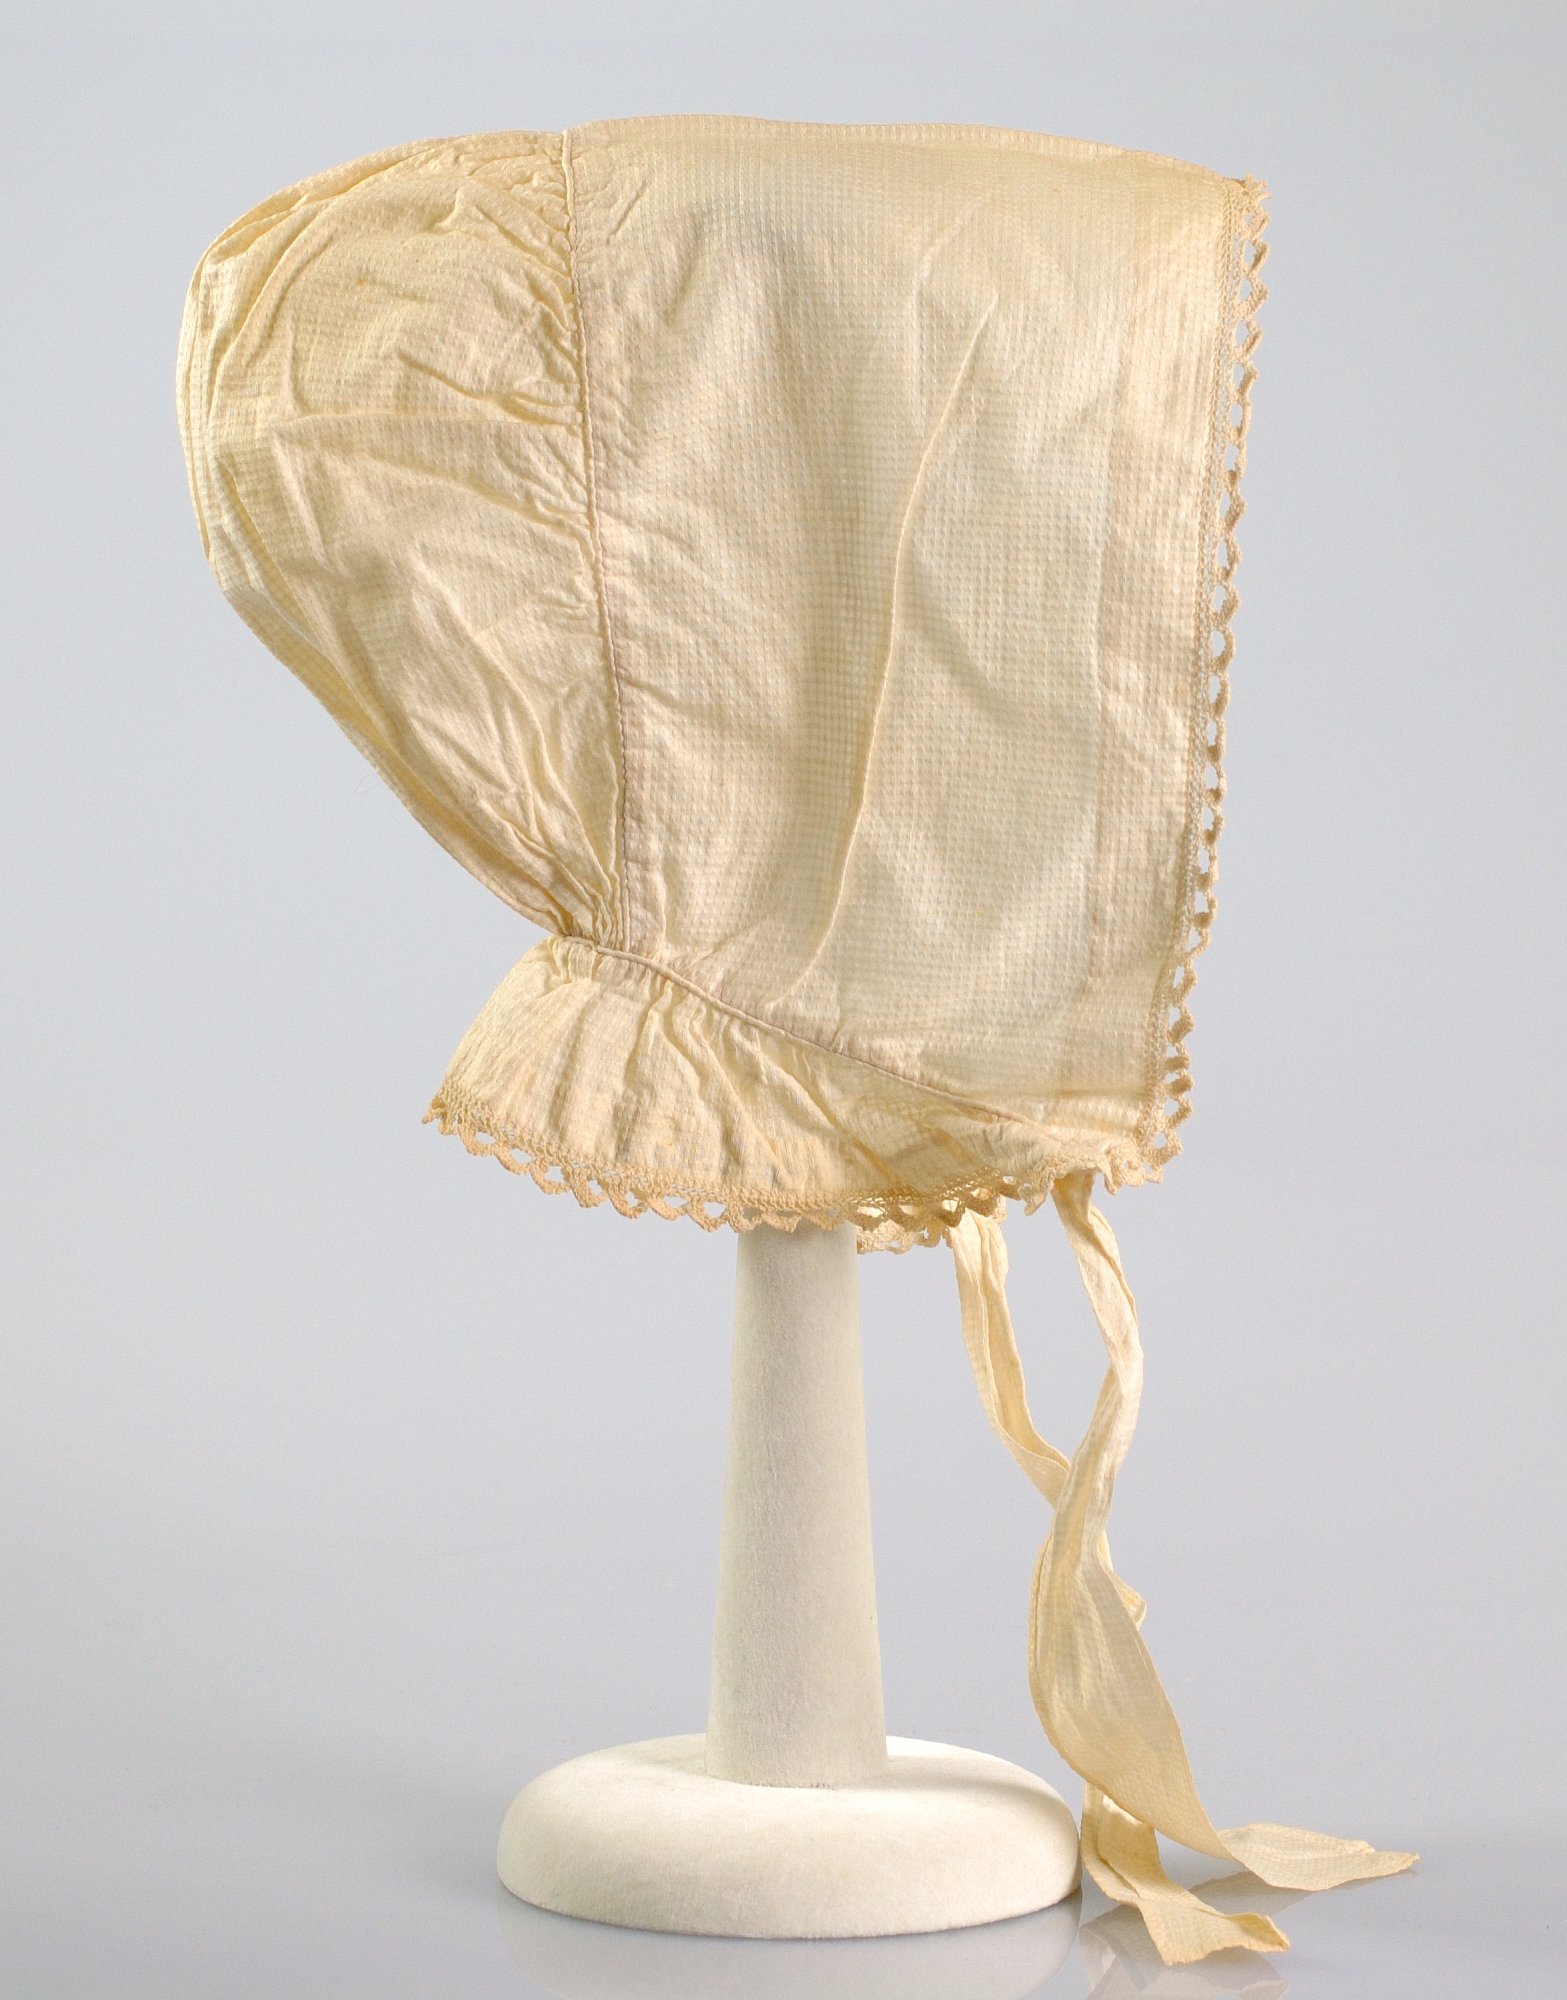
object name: cap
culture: american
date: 1840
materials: cotton